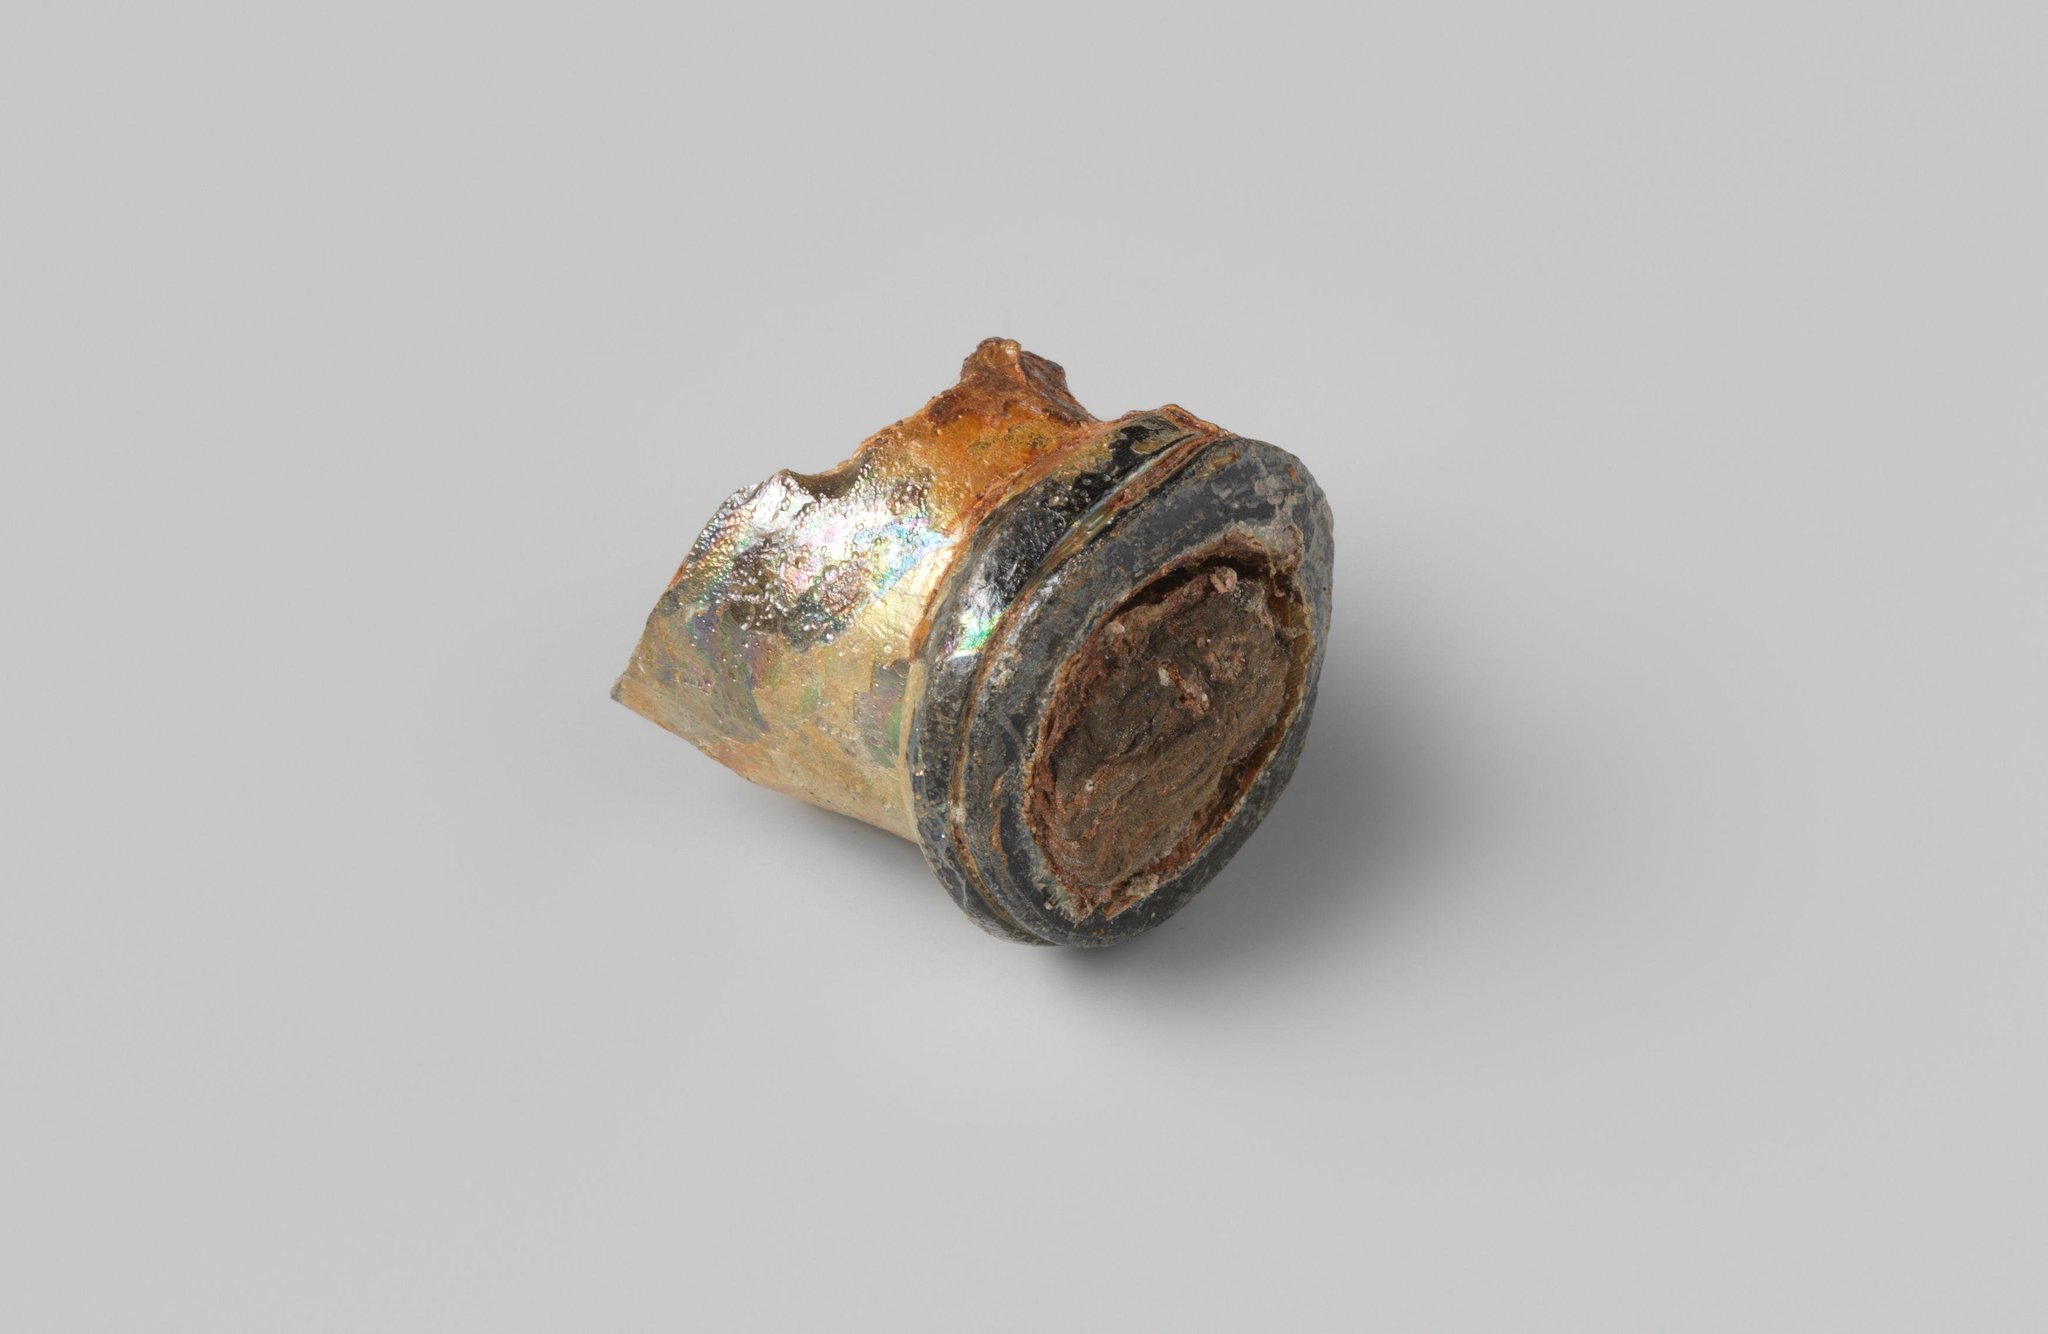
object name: sherd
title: Mond met kurk van een wijnfles uit het wrak van de Oostindiëvaarder Hollandia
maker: Anonymous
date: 1700-1743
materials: cork, glass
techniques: green glass